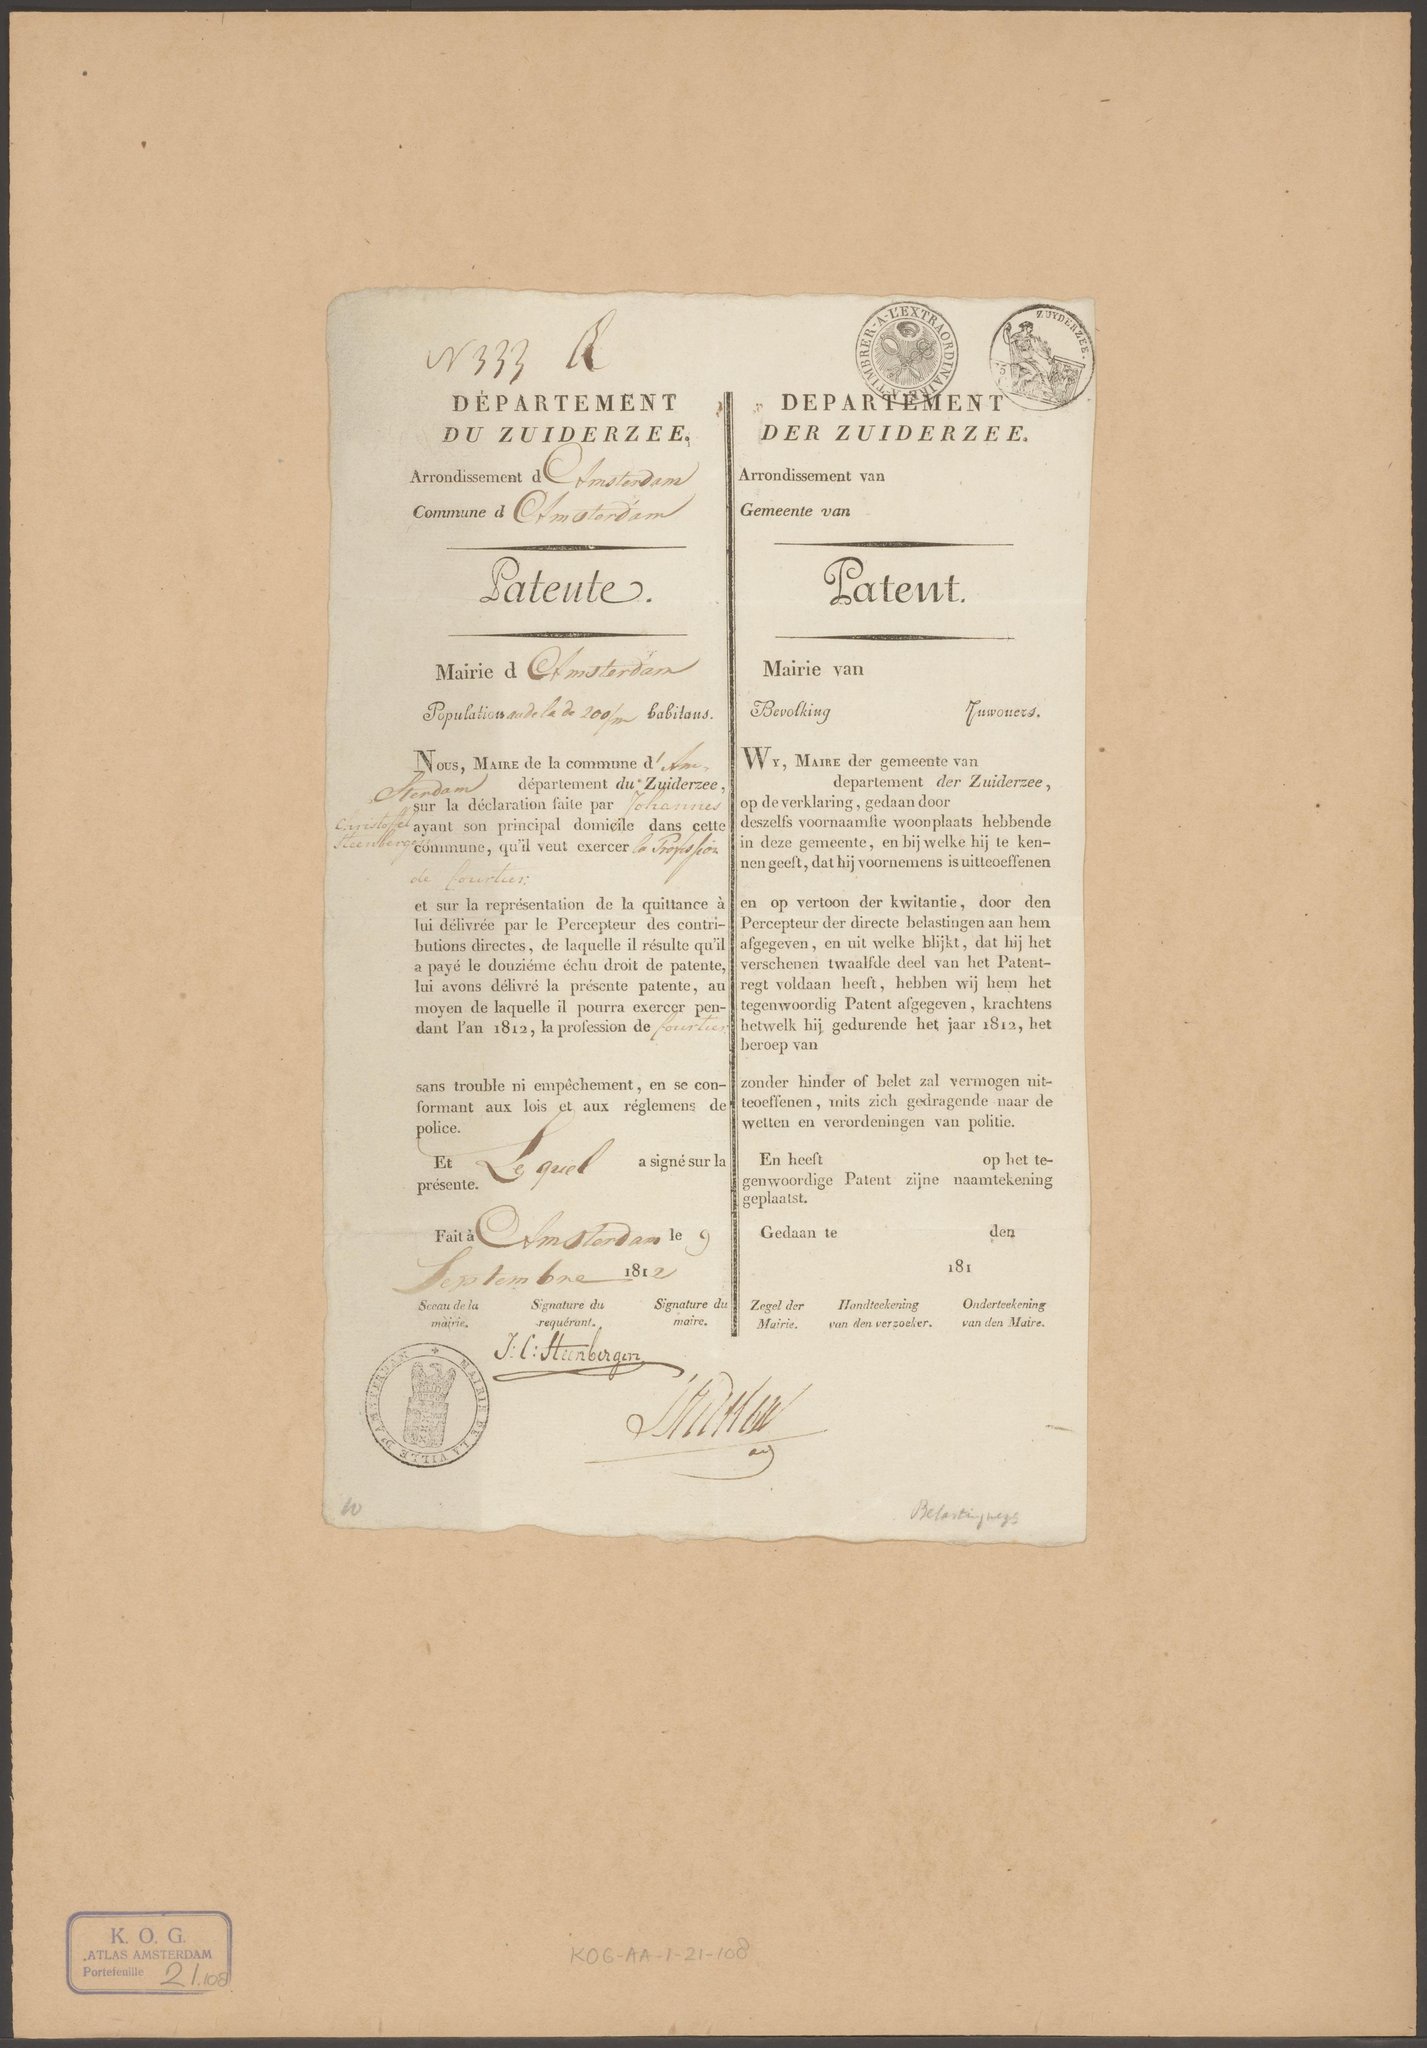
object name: document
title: Akte van patent op naam van Johannes Christoffel Steenbergen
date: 1812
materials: ink, paper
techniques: letterpress printing, pen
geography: amsterdam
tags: johannes christoffel steenbergen, tax collection, municipal government, taxes and financial administration, merchant, salesman, amsterdam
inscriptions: collector's mark: Lugt 1641b, stamp: ‘Mairie de la ville d'Amsterdam’, stamp: ‘Zuyderzee. 75 C.’, stamp: ‘A l'extraordinaire a timbrer.’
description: Het recht van patent om het beroep van courtier uit te oefenen. Onderwerpsrubriek binnen de Atlas Amsterdam: Belastingen.